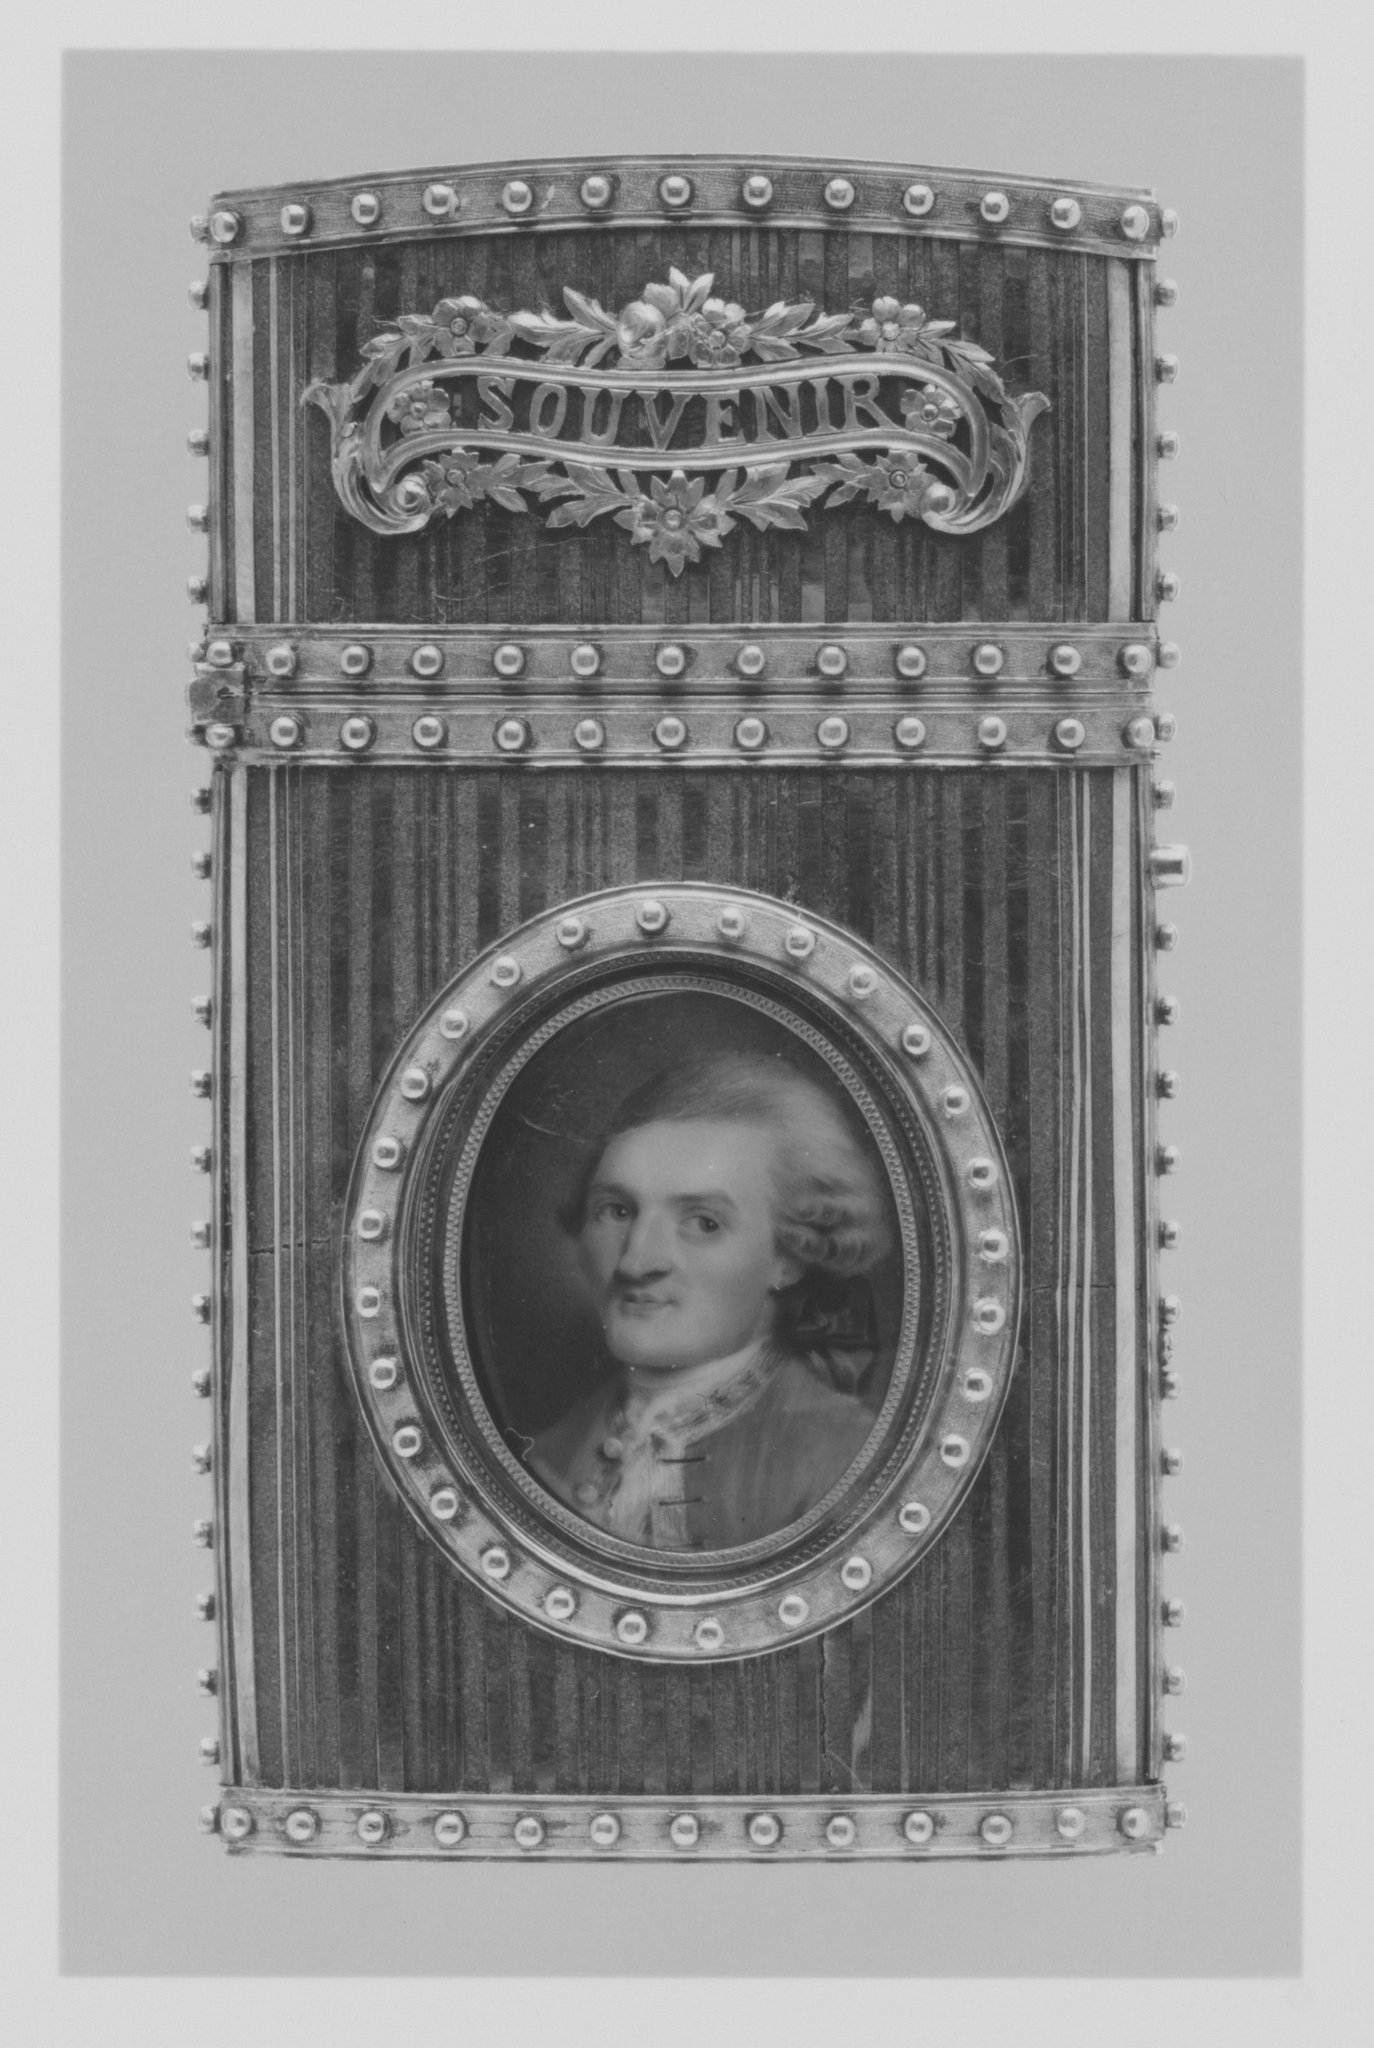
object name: souvenir, painting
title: Souvenir with portrait of a man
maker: french painter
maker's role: artist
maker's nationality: french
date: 1778-1779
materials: enamel, gold, ivory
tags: men,portraits